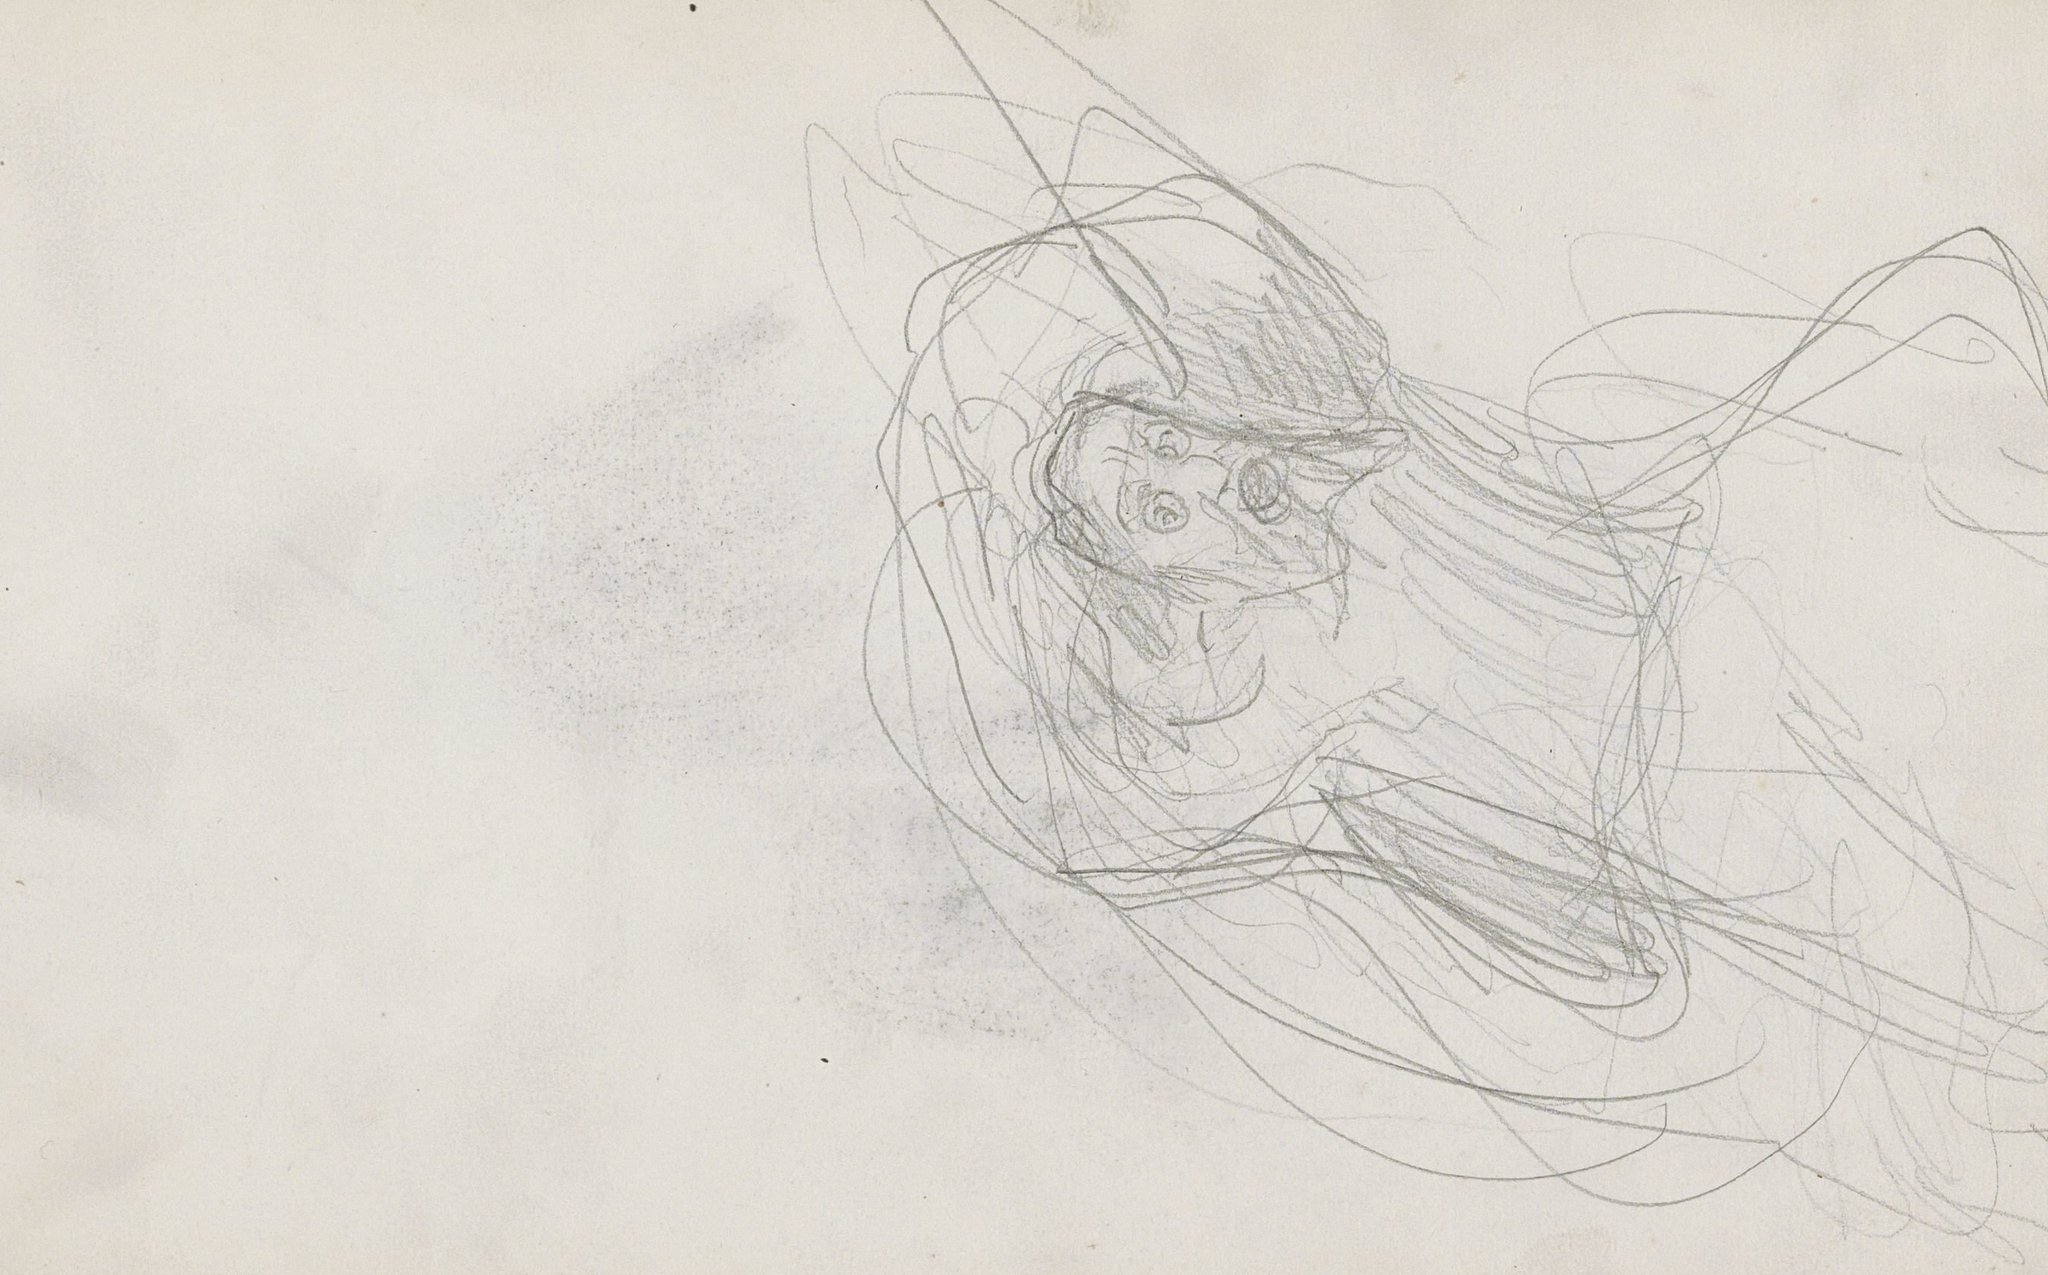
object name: sketchbook leaf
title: Man met opengesperde mond en ogen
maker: bastiaan de poorter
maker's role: painter, print maker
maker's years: 1813-1880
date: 1858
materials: paper, pencil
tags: mouth wide open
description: Blad 19 recto uit een gecombineerd album amicorum en schetsboek met in totaal 39 bladen.